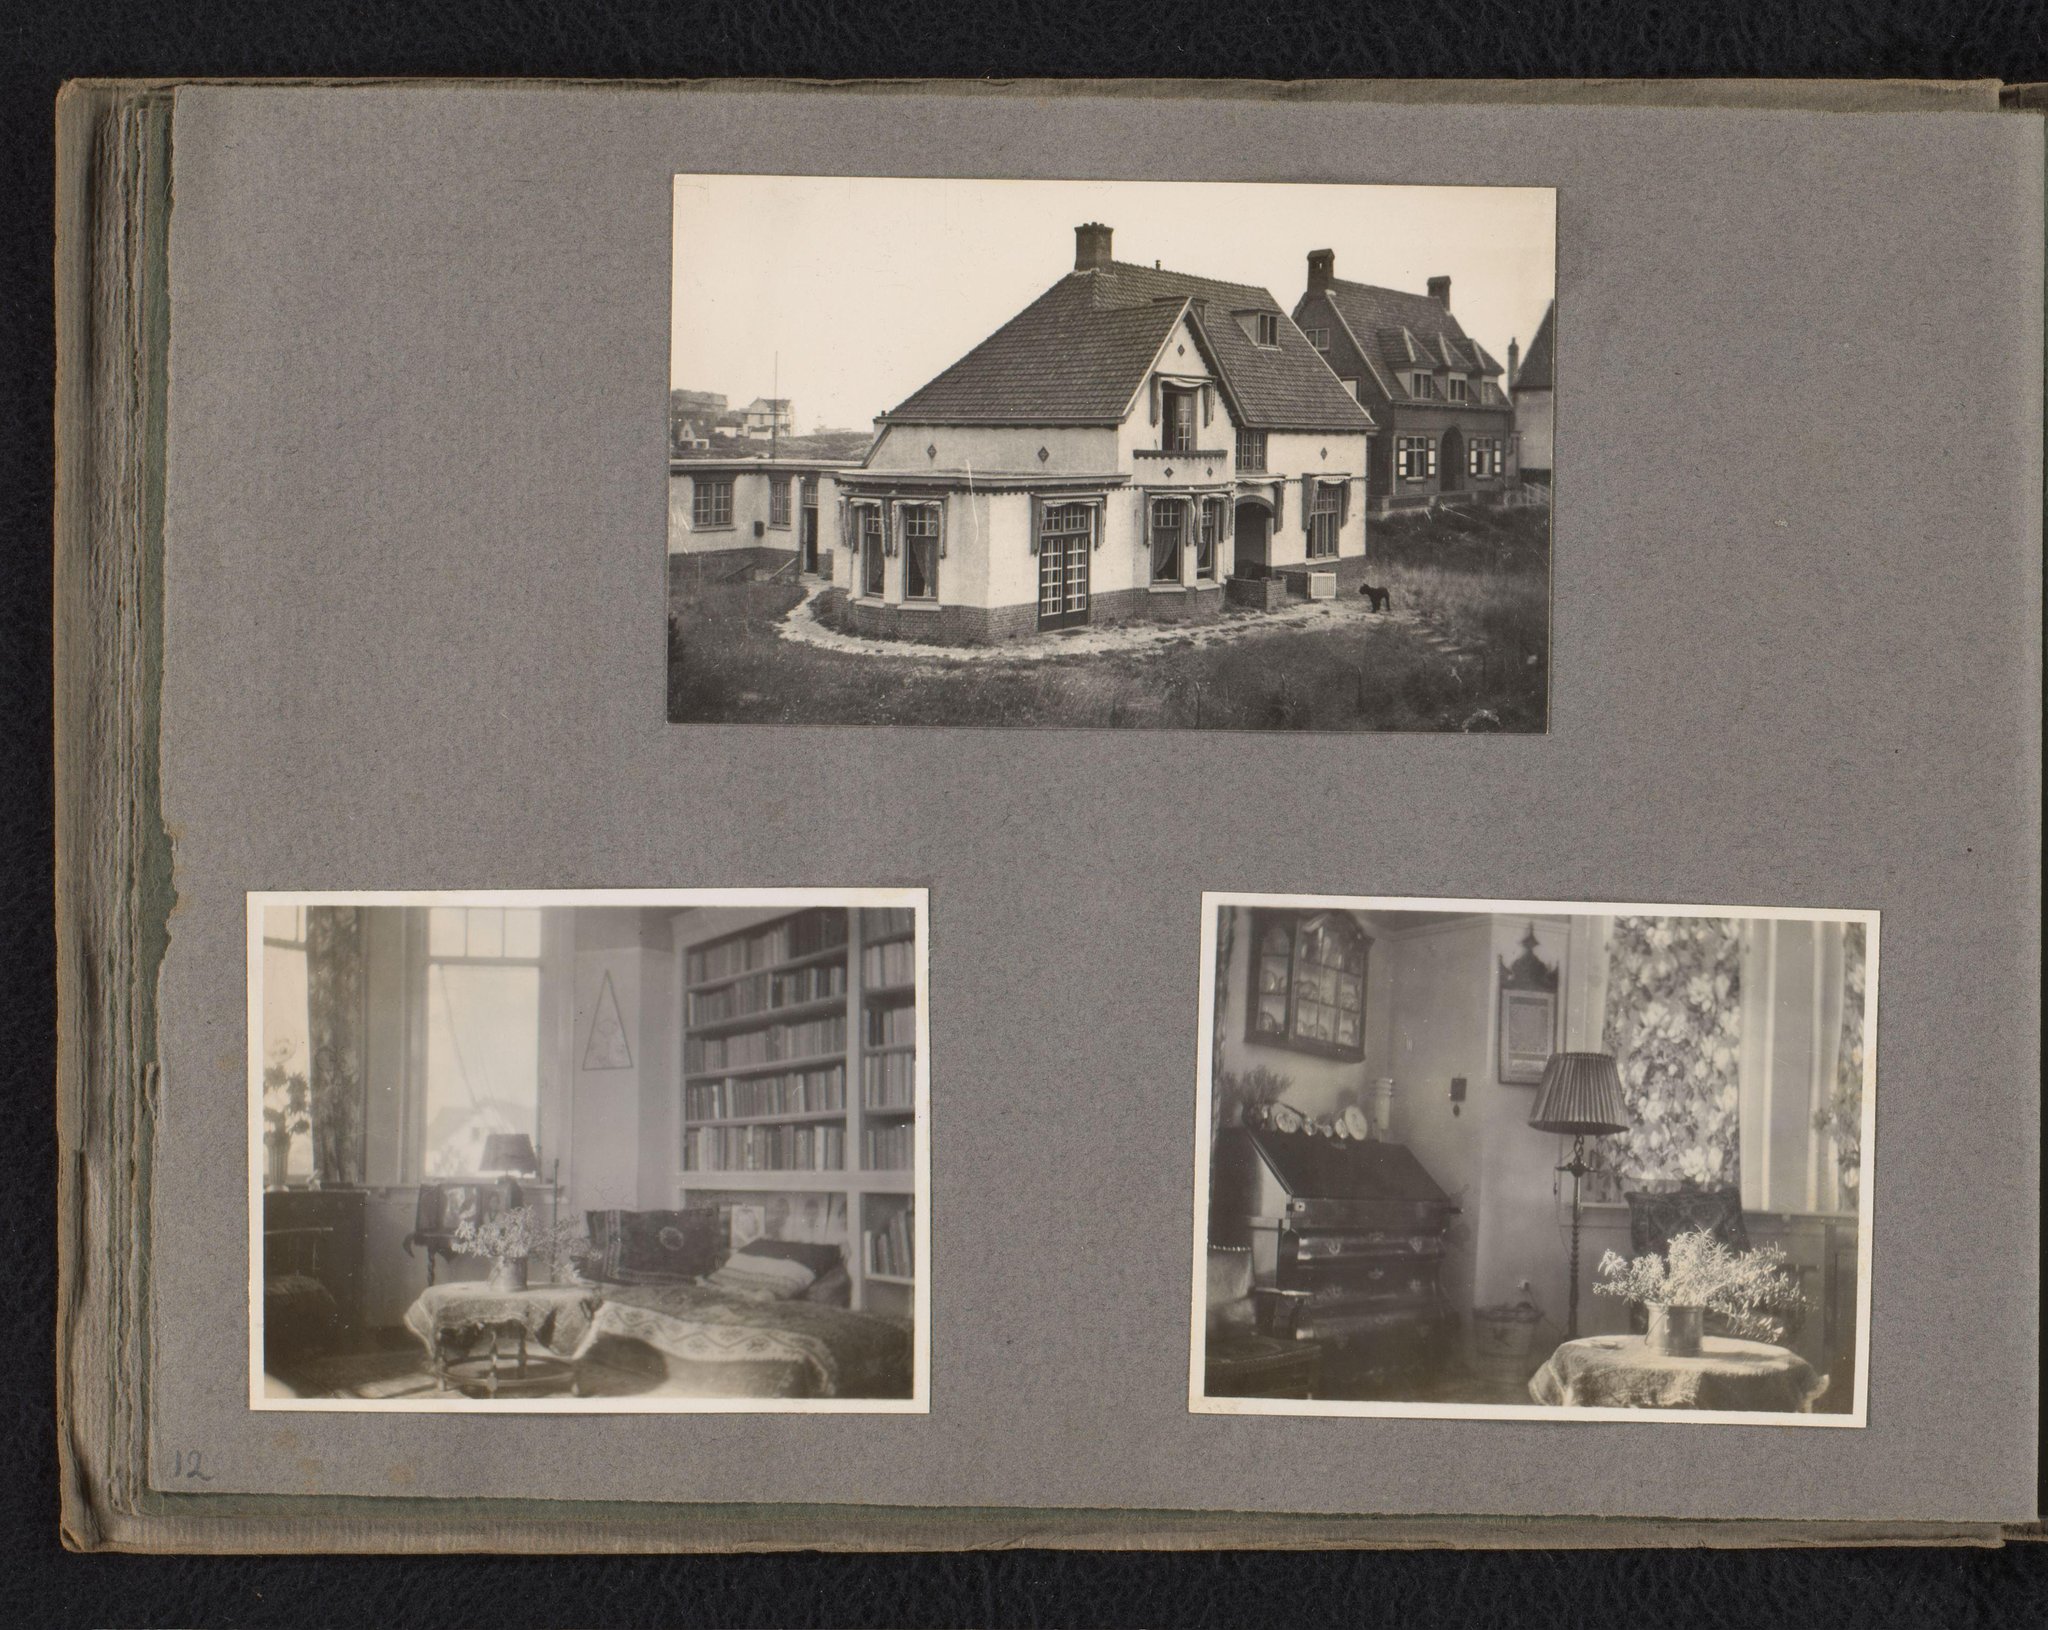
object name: album leaf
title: Drie foto's van het vakantiehuis van familie Onnen-Van den Berg in Noordwijk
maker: Anonymous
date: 1920-1930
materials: paper, cardboard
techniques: gelatin silver print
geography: noordwijk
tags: exterior ~ representation of a building, interior ~ representation of a building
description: Deze foto's maken deel uit van een album.